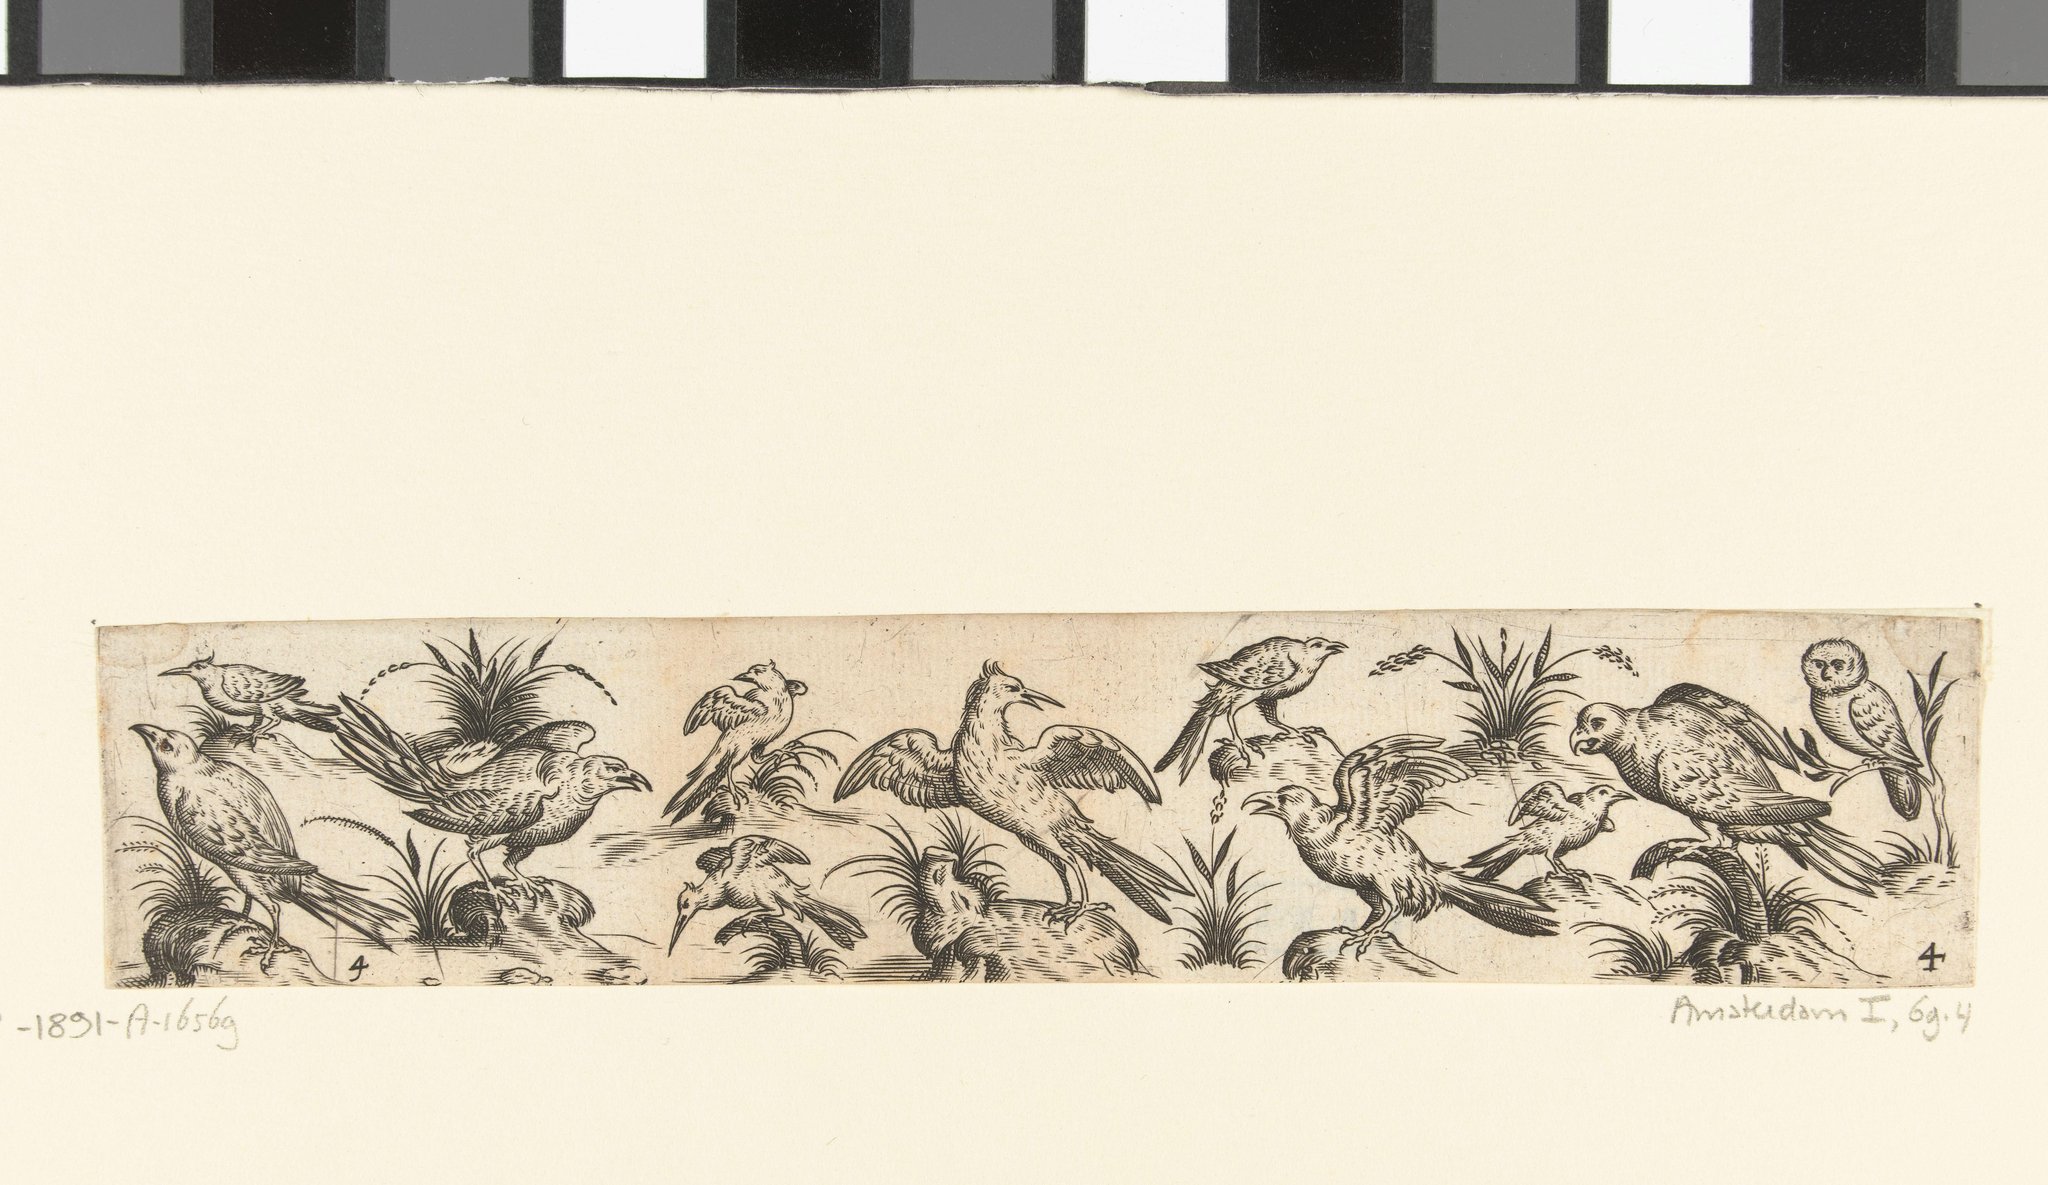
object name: ornament print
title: Fries met elf vogels, rechts zit een uiltje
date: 1631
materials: paper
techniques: engraving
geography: netherlands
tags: birds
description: De vogel in het midden heeft de vleugels gespreid en kijkt achterom. Blad 4 uit serie van 12 genummerde bladen.